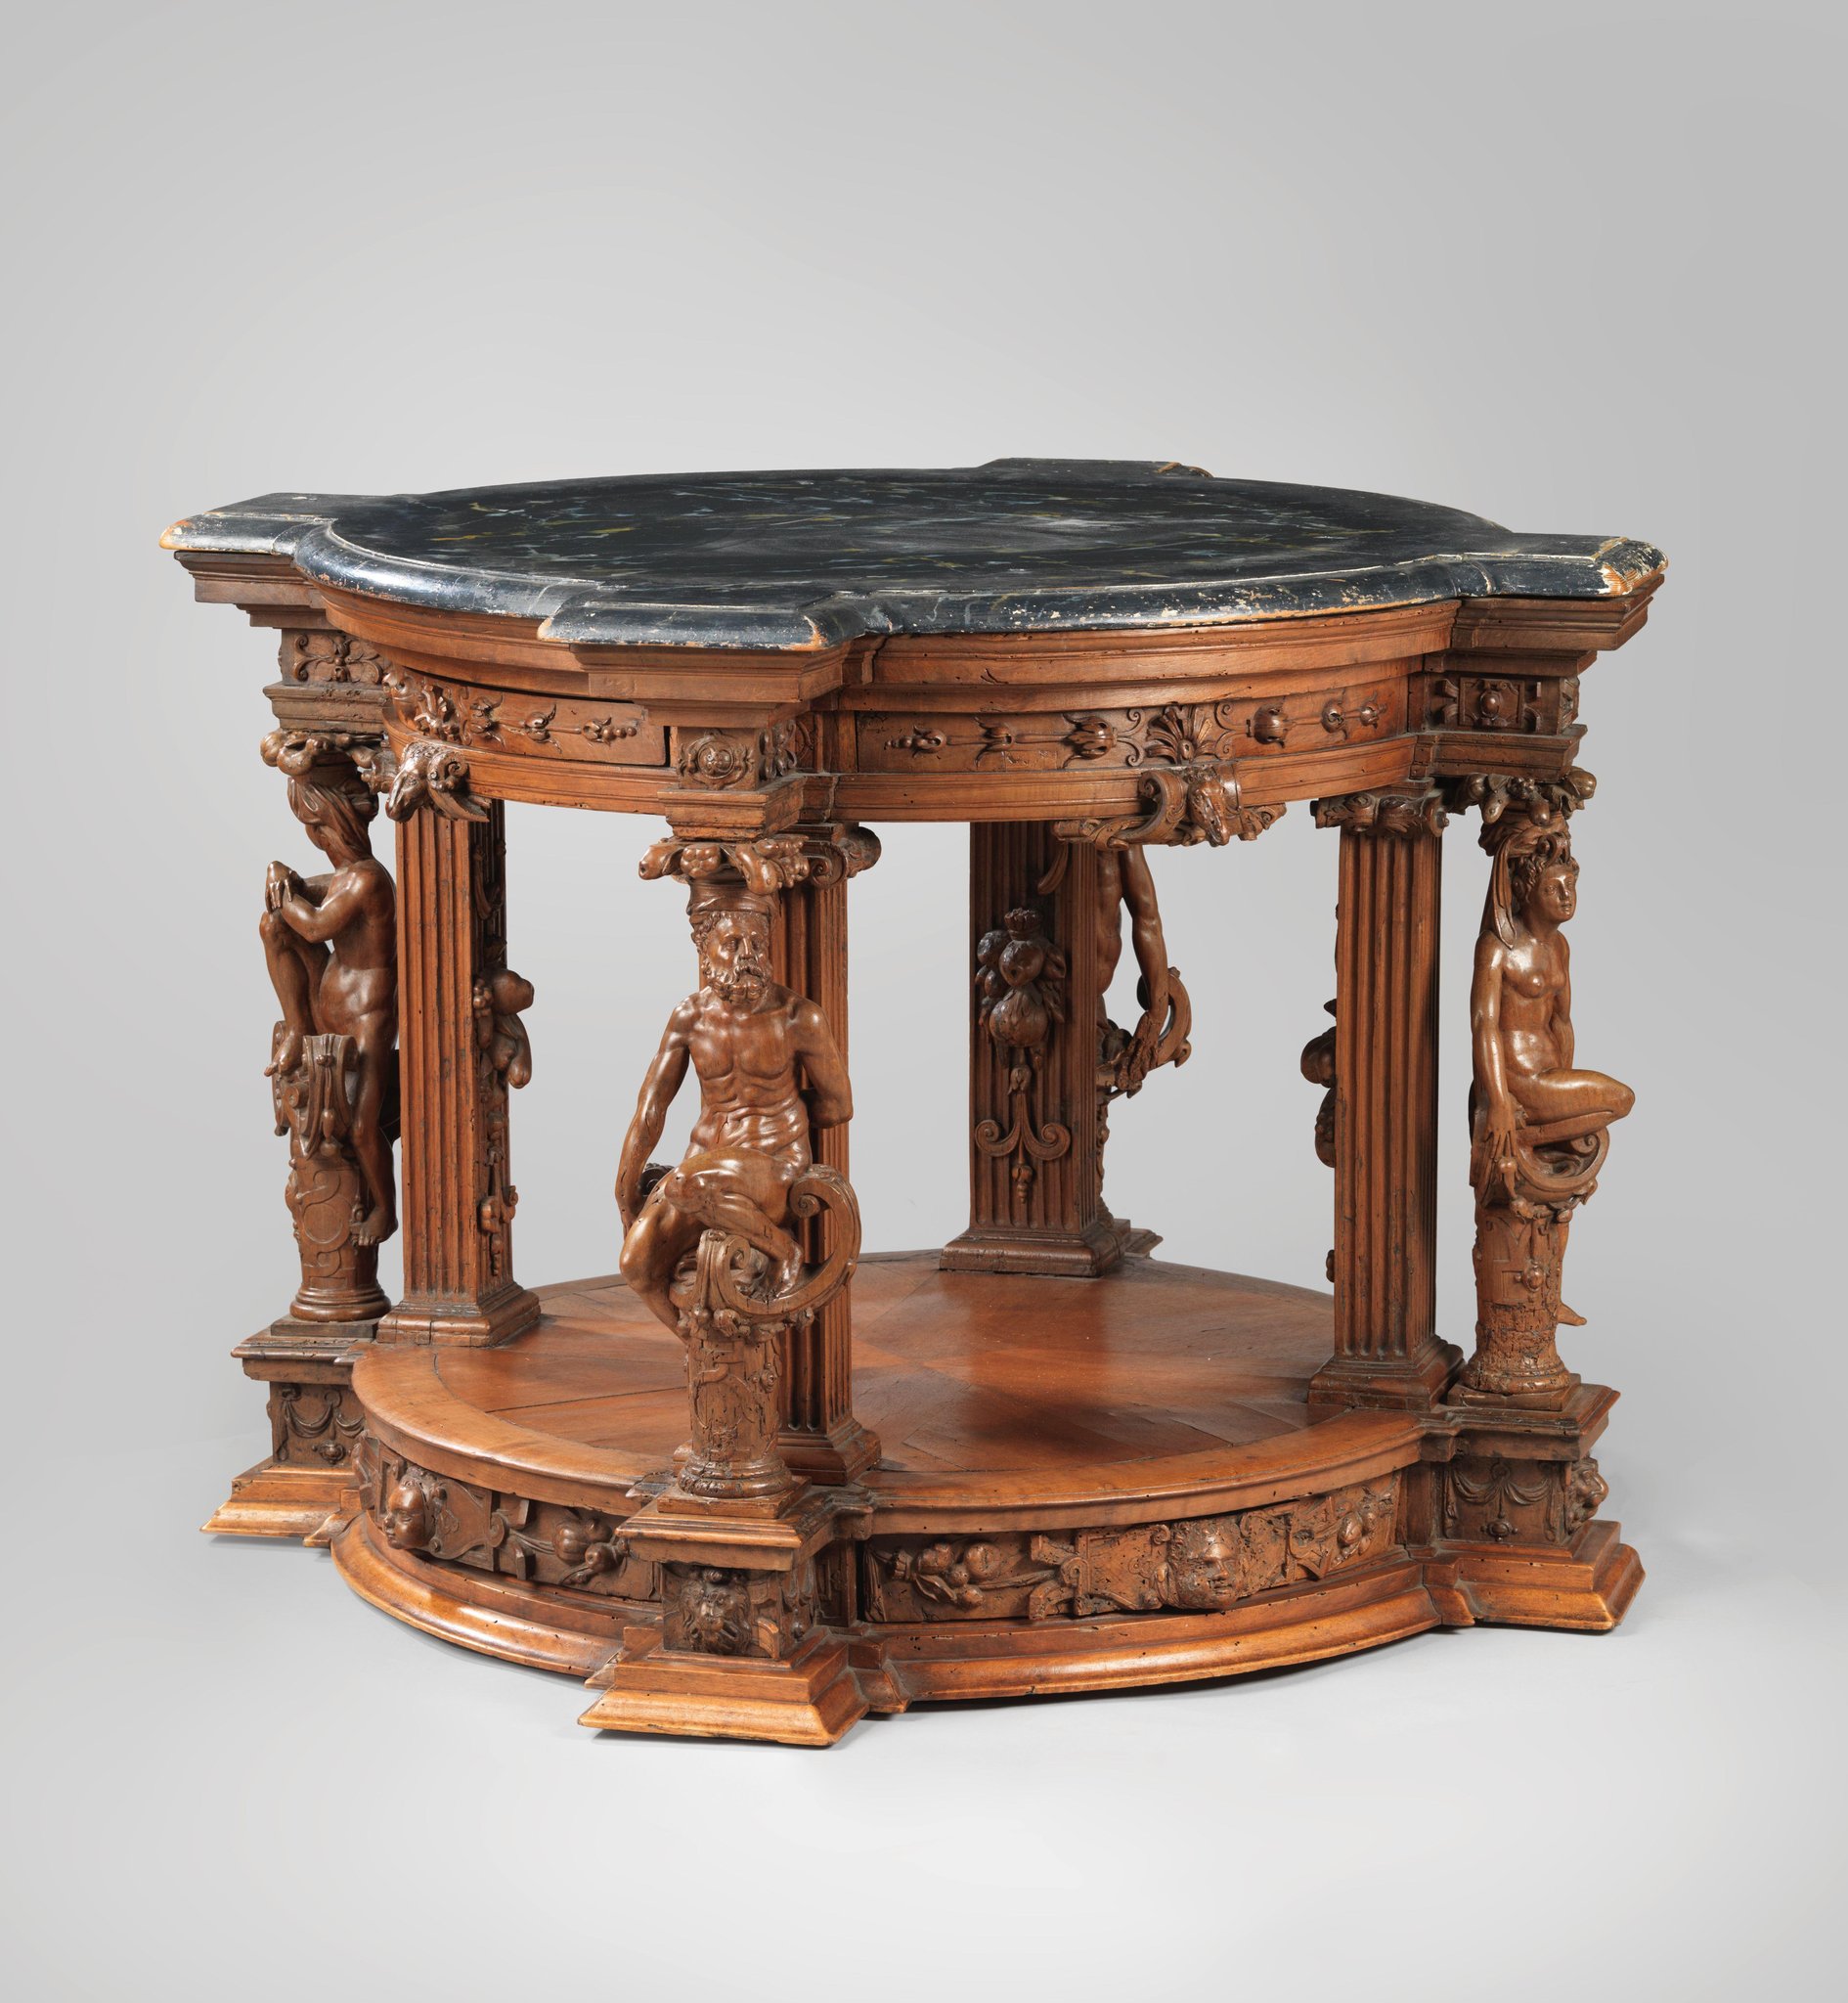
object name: table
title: Ronde tafel van notenhout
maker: Anonymous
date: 1550-1600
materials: wood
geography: france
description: Ronde tafel van notenhout, op voetstuk met vier schuifladen, waarop vier gecanneleerde vierkante Ionische zuilen zijn geplaatst. Tussen verkroppingen in voetstuk en regel zijn twee naakte caryatiden en twee naakte atlanten geplaatst, gezeten op een zuilenschacht, waarop toegewende C-voluten. Vruchtentrossen op de hoofden en aan de achterzijde der kolommen. Onder- en bovenfries dragen rondom gestoken versieringen, ondermeer met dieren- en mensenkoppen op rolwerkcartouches. Vloer belijmd in kruismotief.